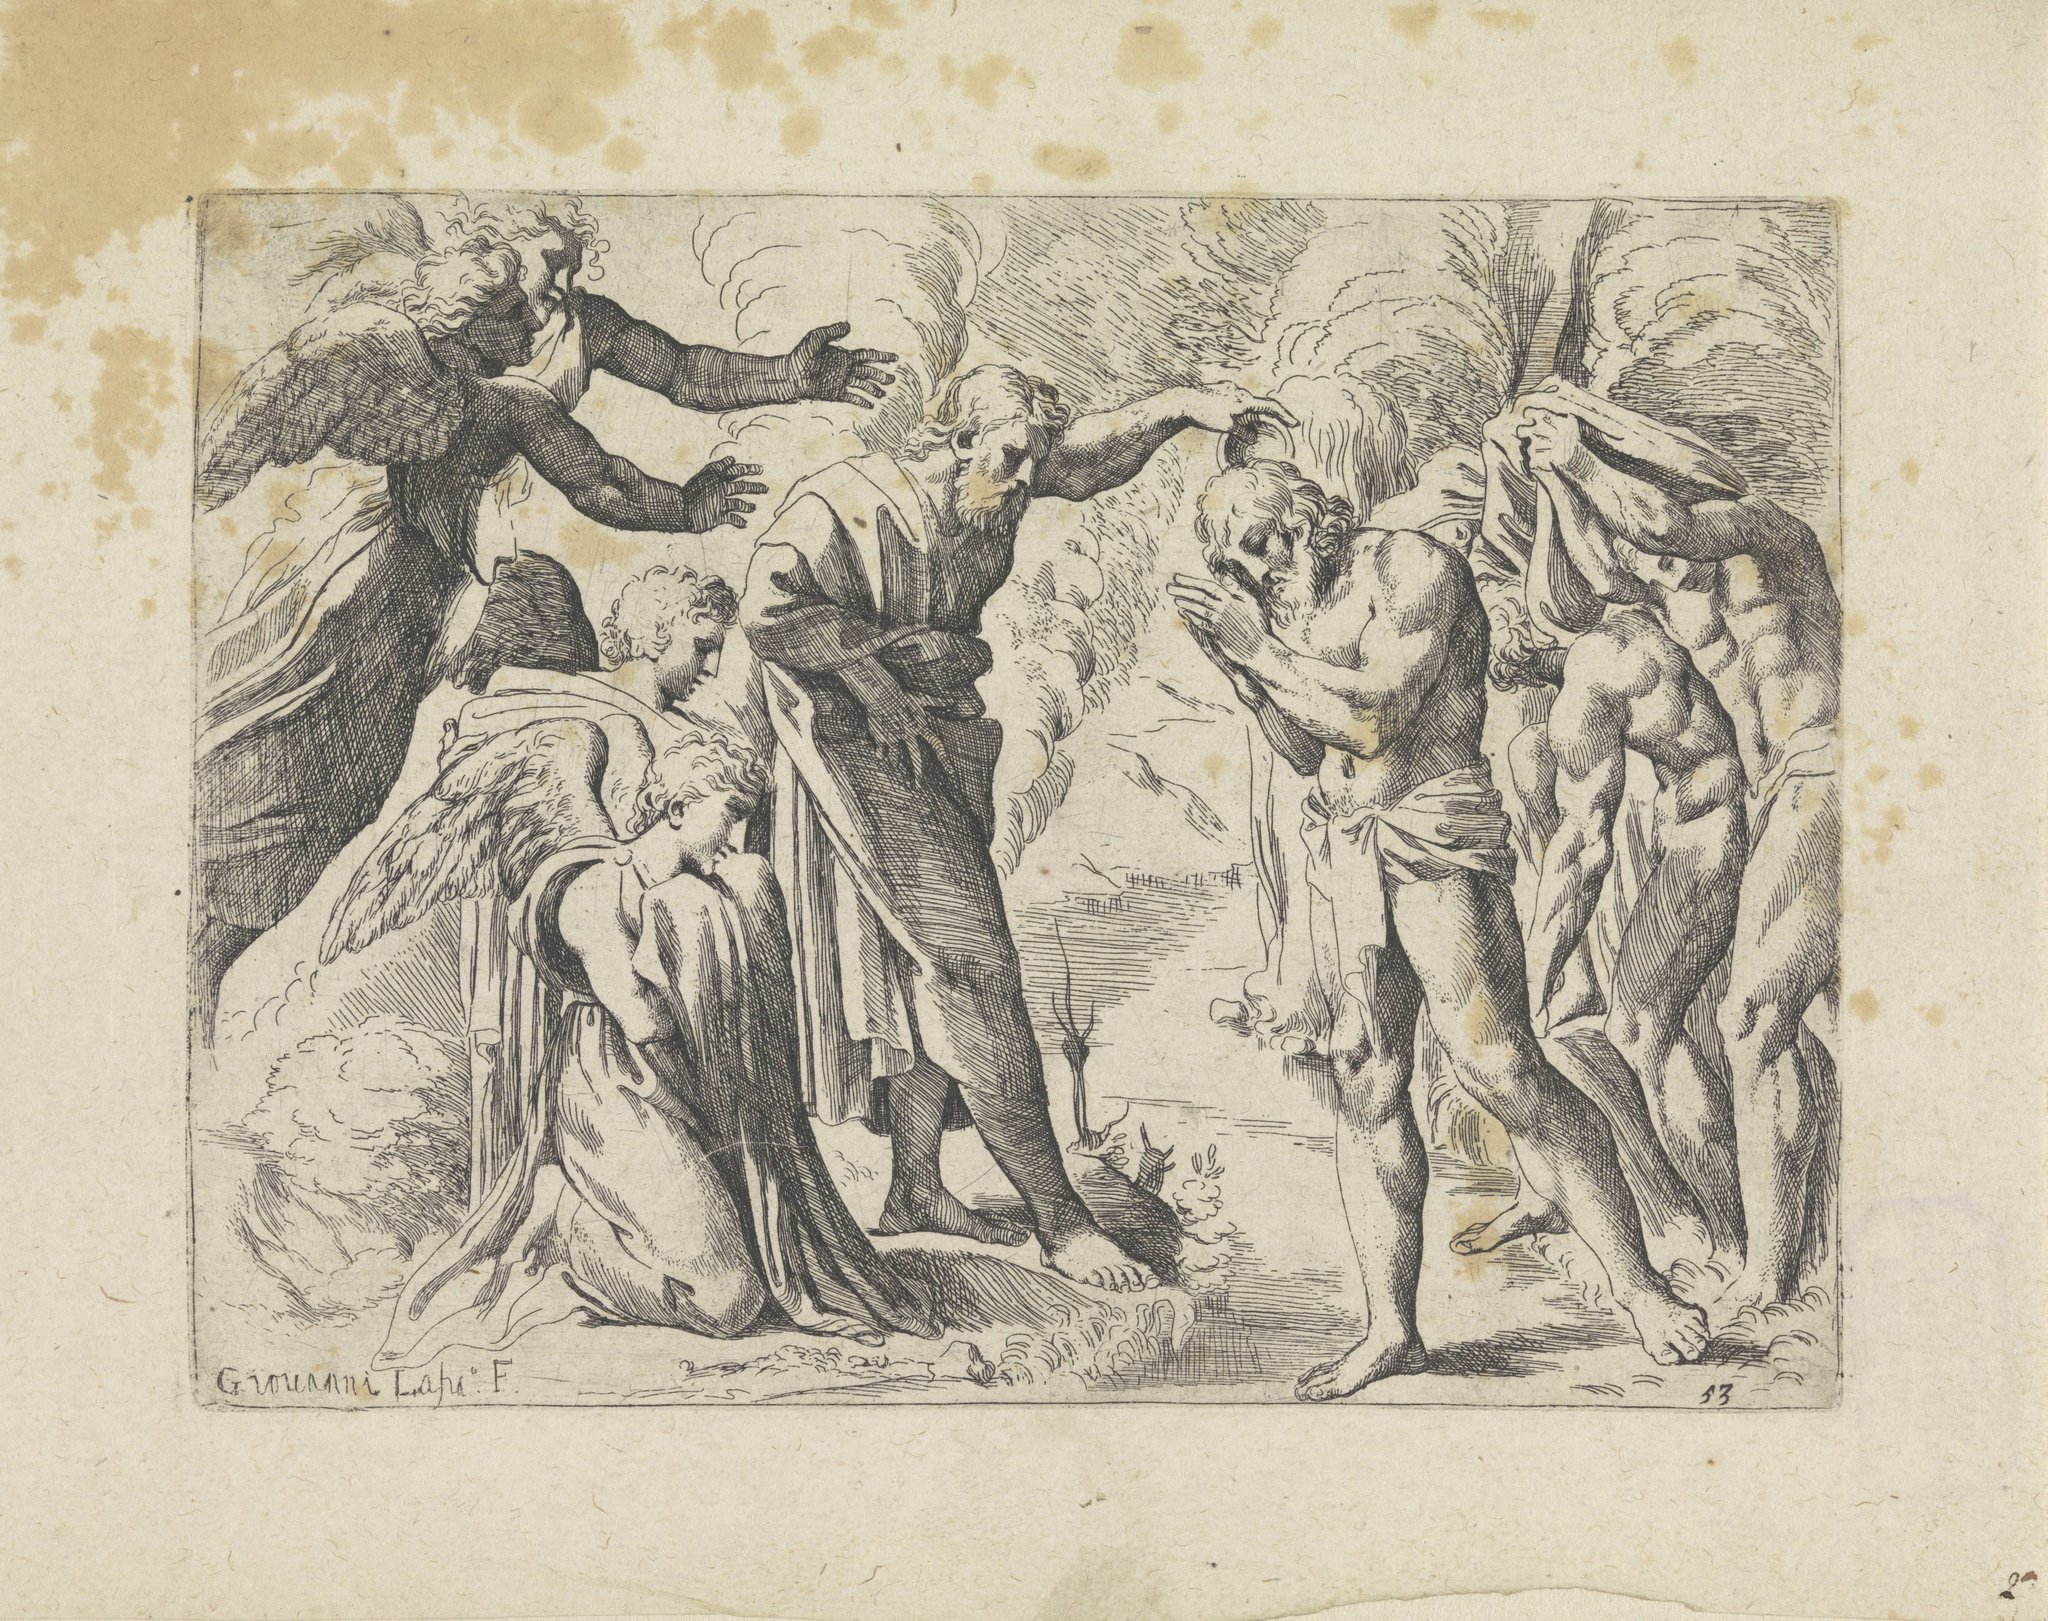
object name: print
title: Historia del Testamento Vecchio / Dipinta in Roma nel Vaticano da Raffaelle di Urbin (...)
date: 1607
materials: paper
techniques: etching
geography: italy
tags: baptism of christ in the river jordan: john the baptist pouring out water on christ's head: the holy ghost descends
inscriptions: number: ‘2’, collector's mark: ‘Hinloopen’, collector's mark: Lugt 11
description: Op een blad geplakt met rechtsboven handgeschreven in pen in bruin: 122. Prent uit een reeks van 54 genummerde prenten naar schilderingen in de Loggia van Rafael in het Vaticaan.